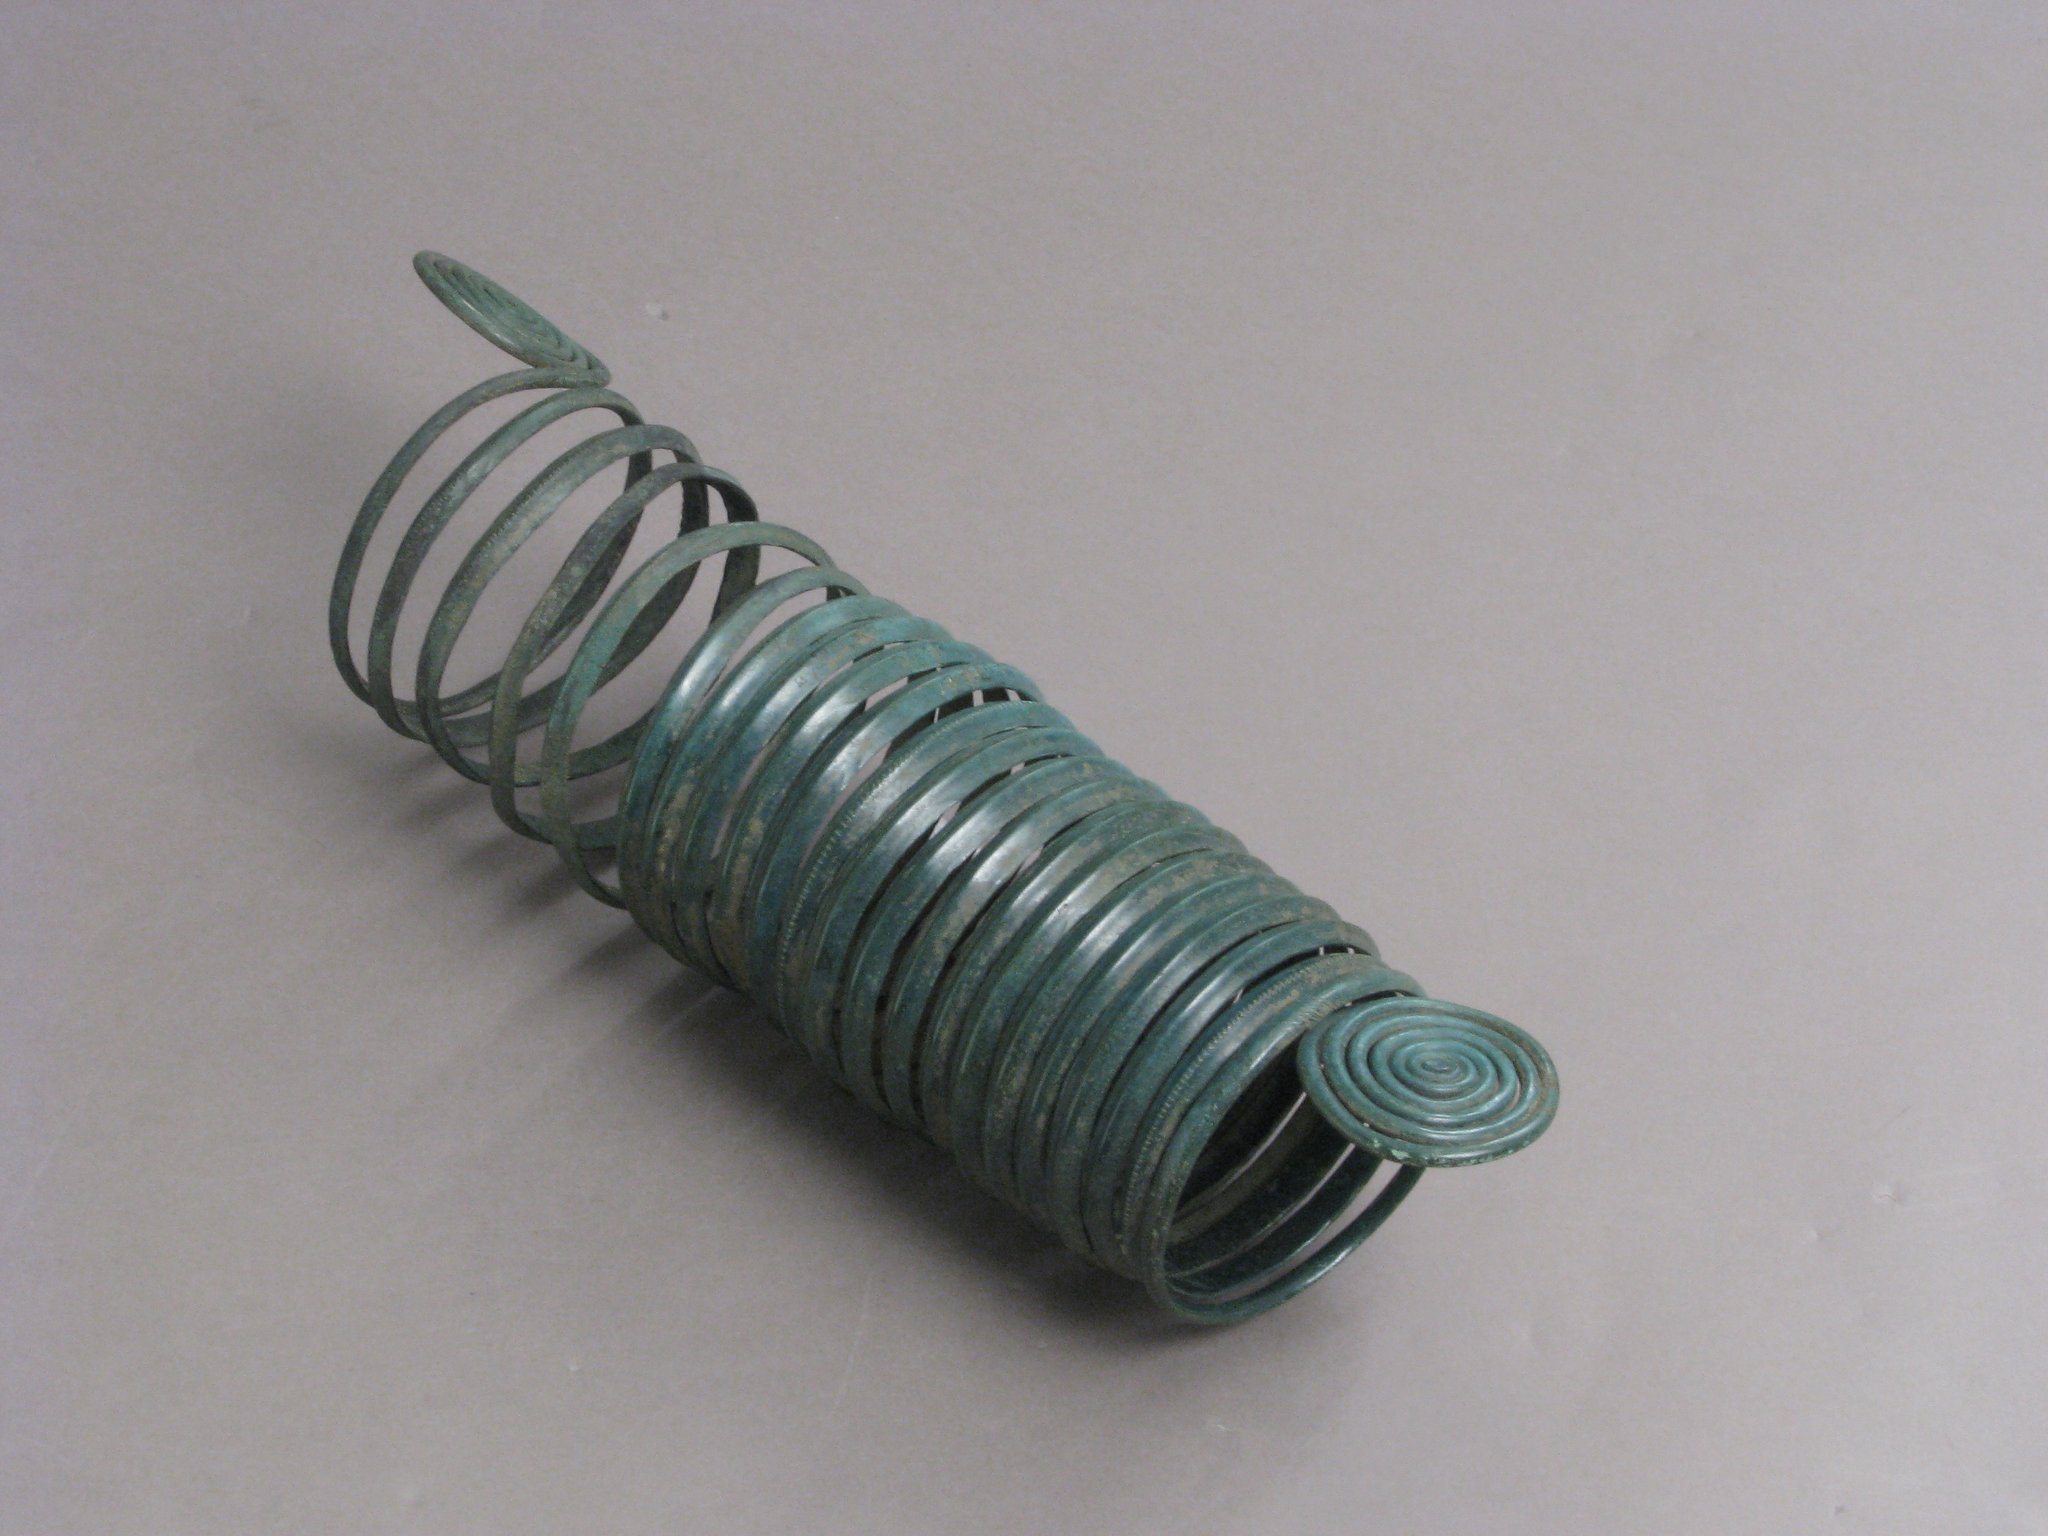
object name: armband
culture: european bronze age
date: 1200-900 BCE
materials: copper alloy